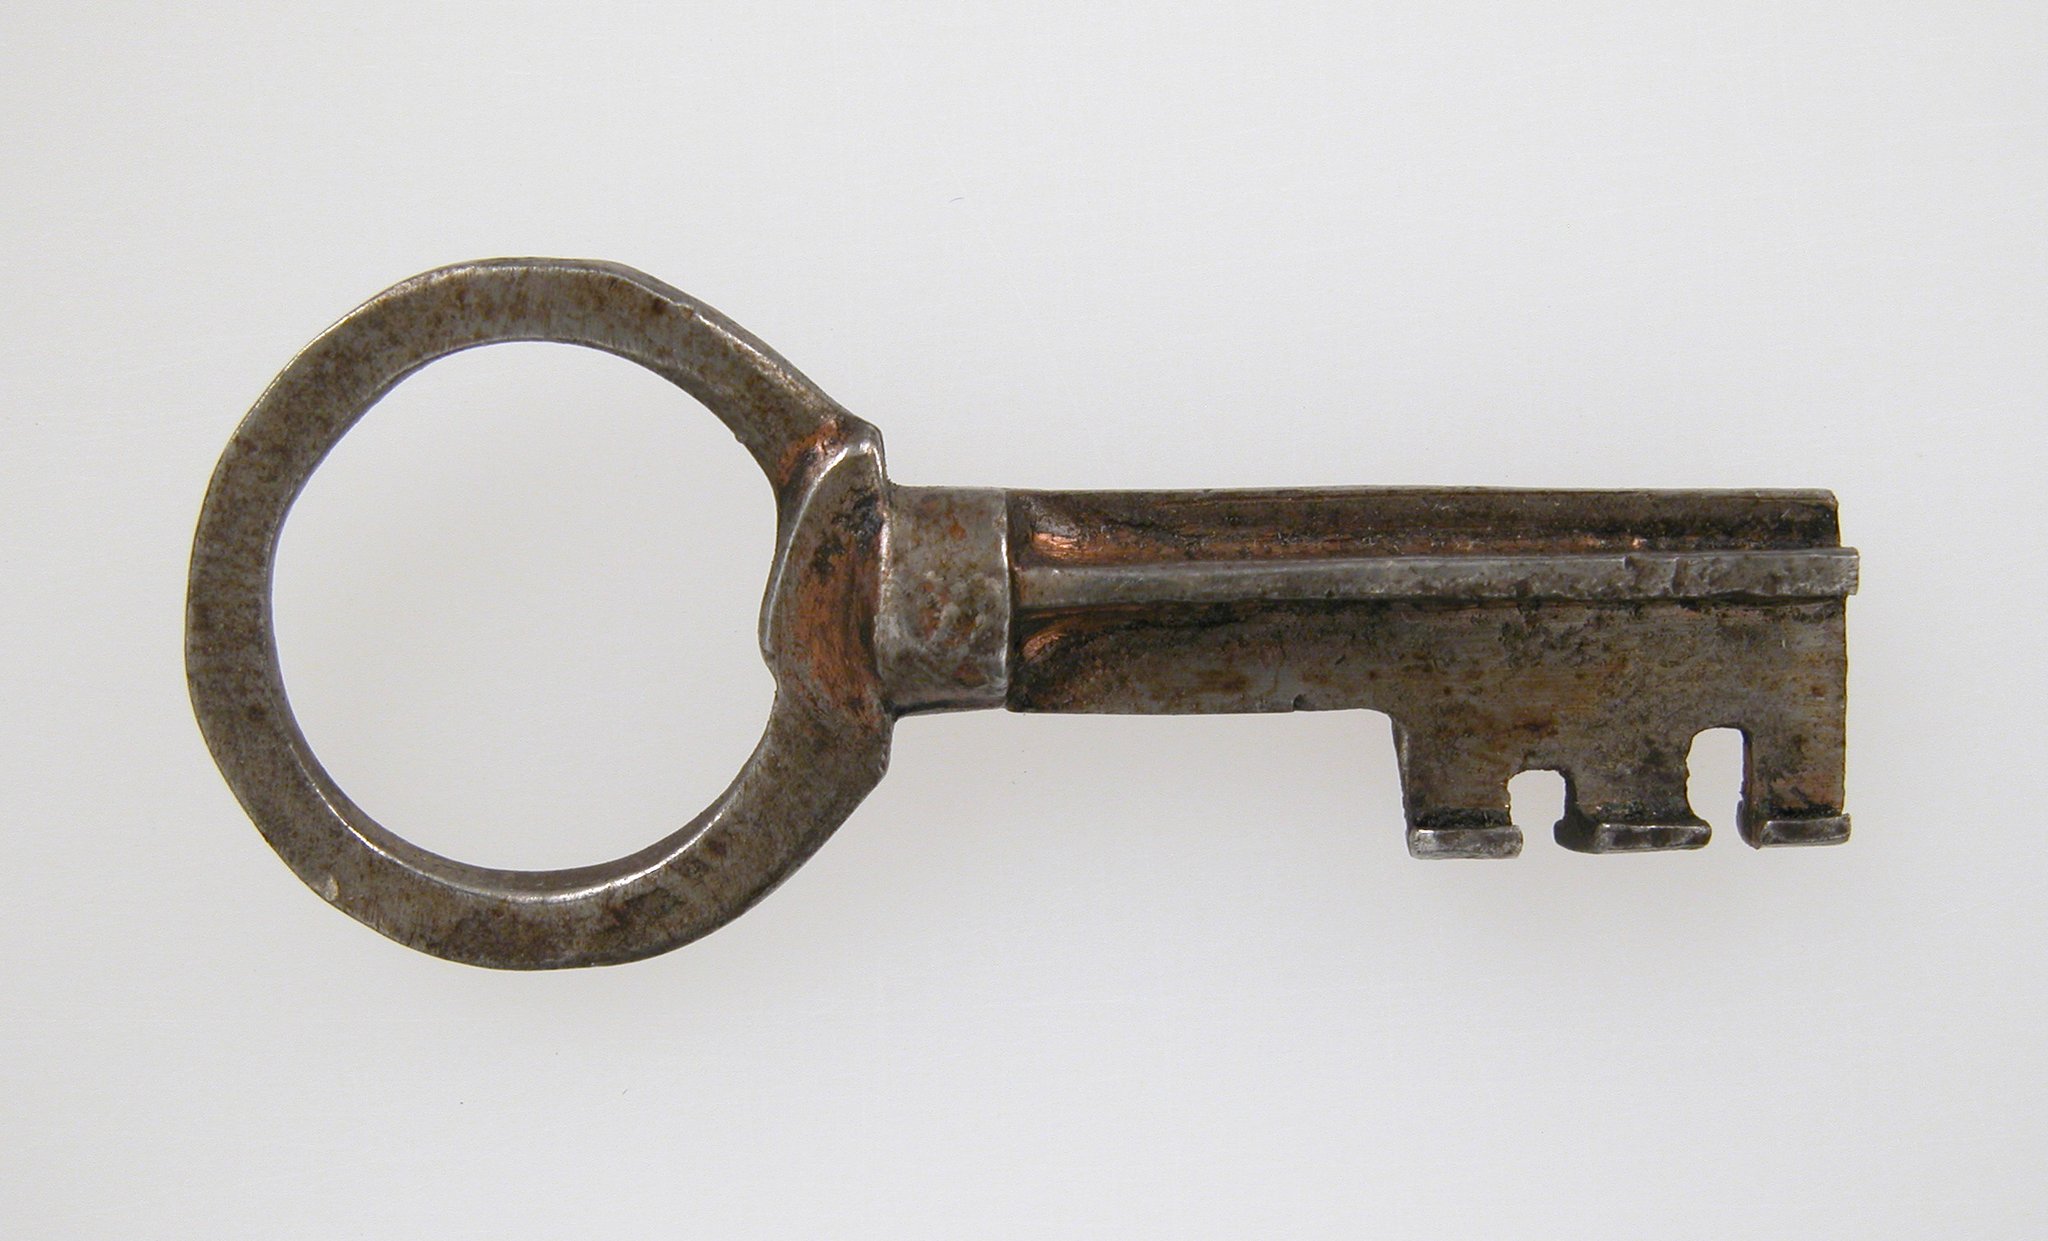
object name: key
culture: german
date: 1301-1400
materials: iron